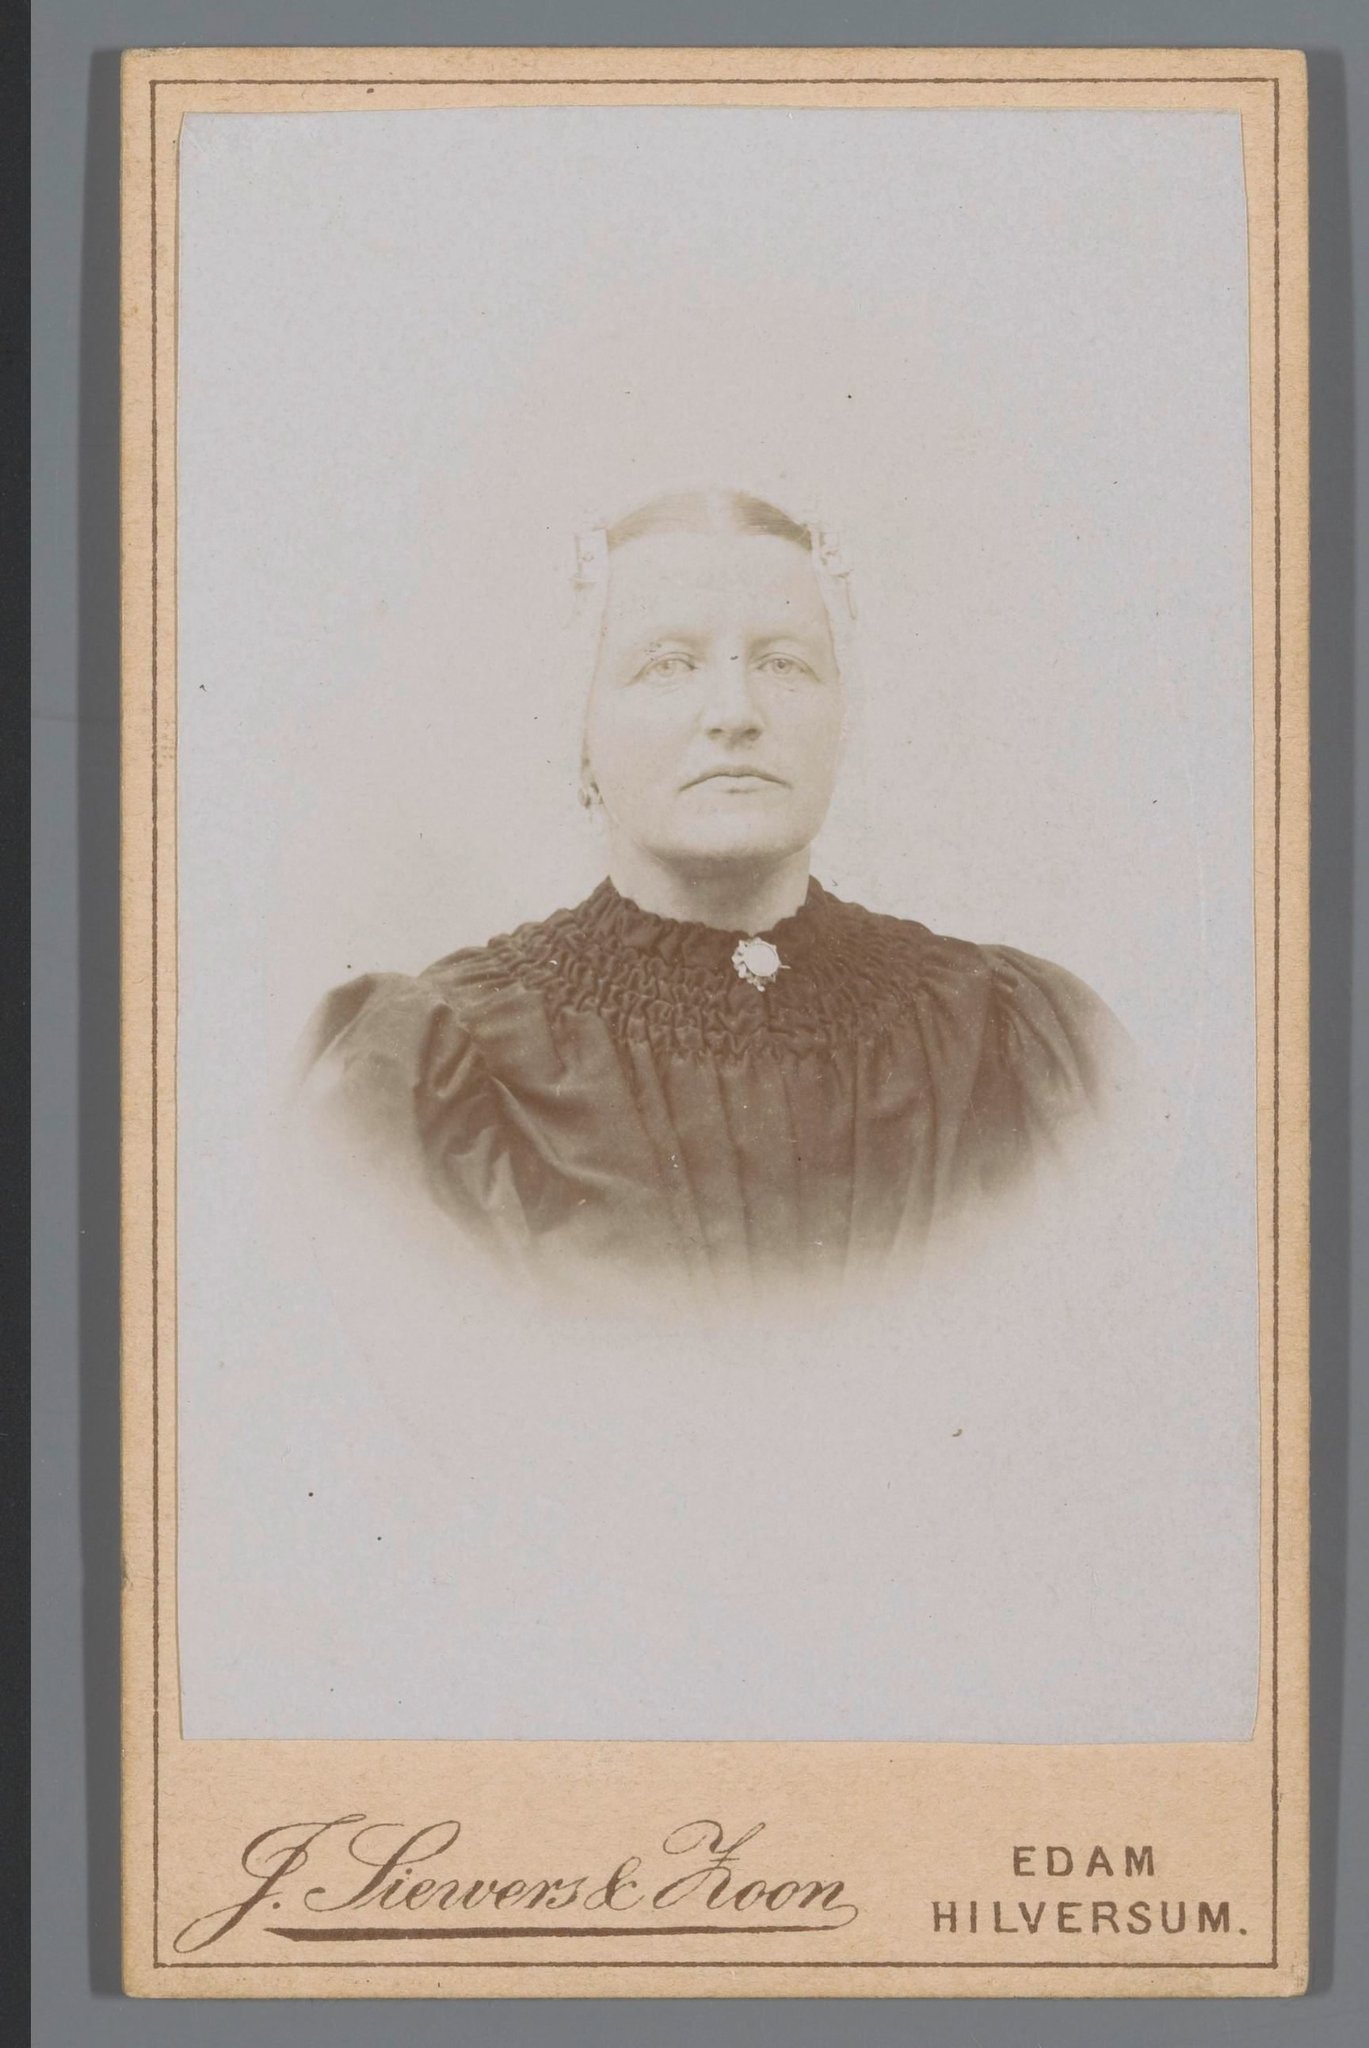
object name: photograph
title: Portret van Maartje Haan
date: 1890-1918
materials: cardboard, celluloid, paper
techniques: albumen print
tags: historical persons - bb - woman, head-gear: cap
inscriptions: number: ‘16’, inscription: ‘Maartje Haan/ x Dirk Middelbeek’, inscription: ‘Photographische/ ATELIERS/ J. Siewers & Zoon/ EDAM/ HILVERSUM./ Specialiteit in vergrootingen.’